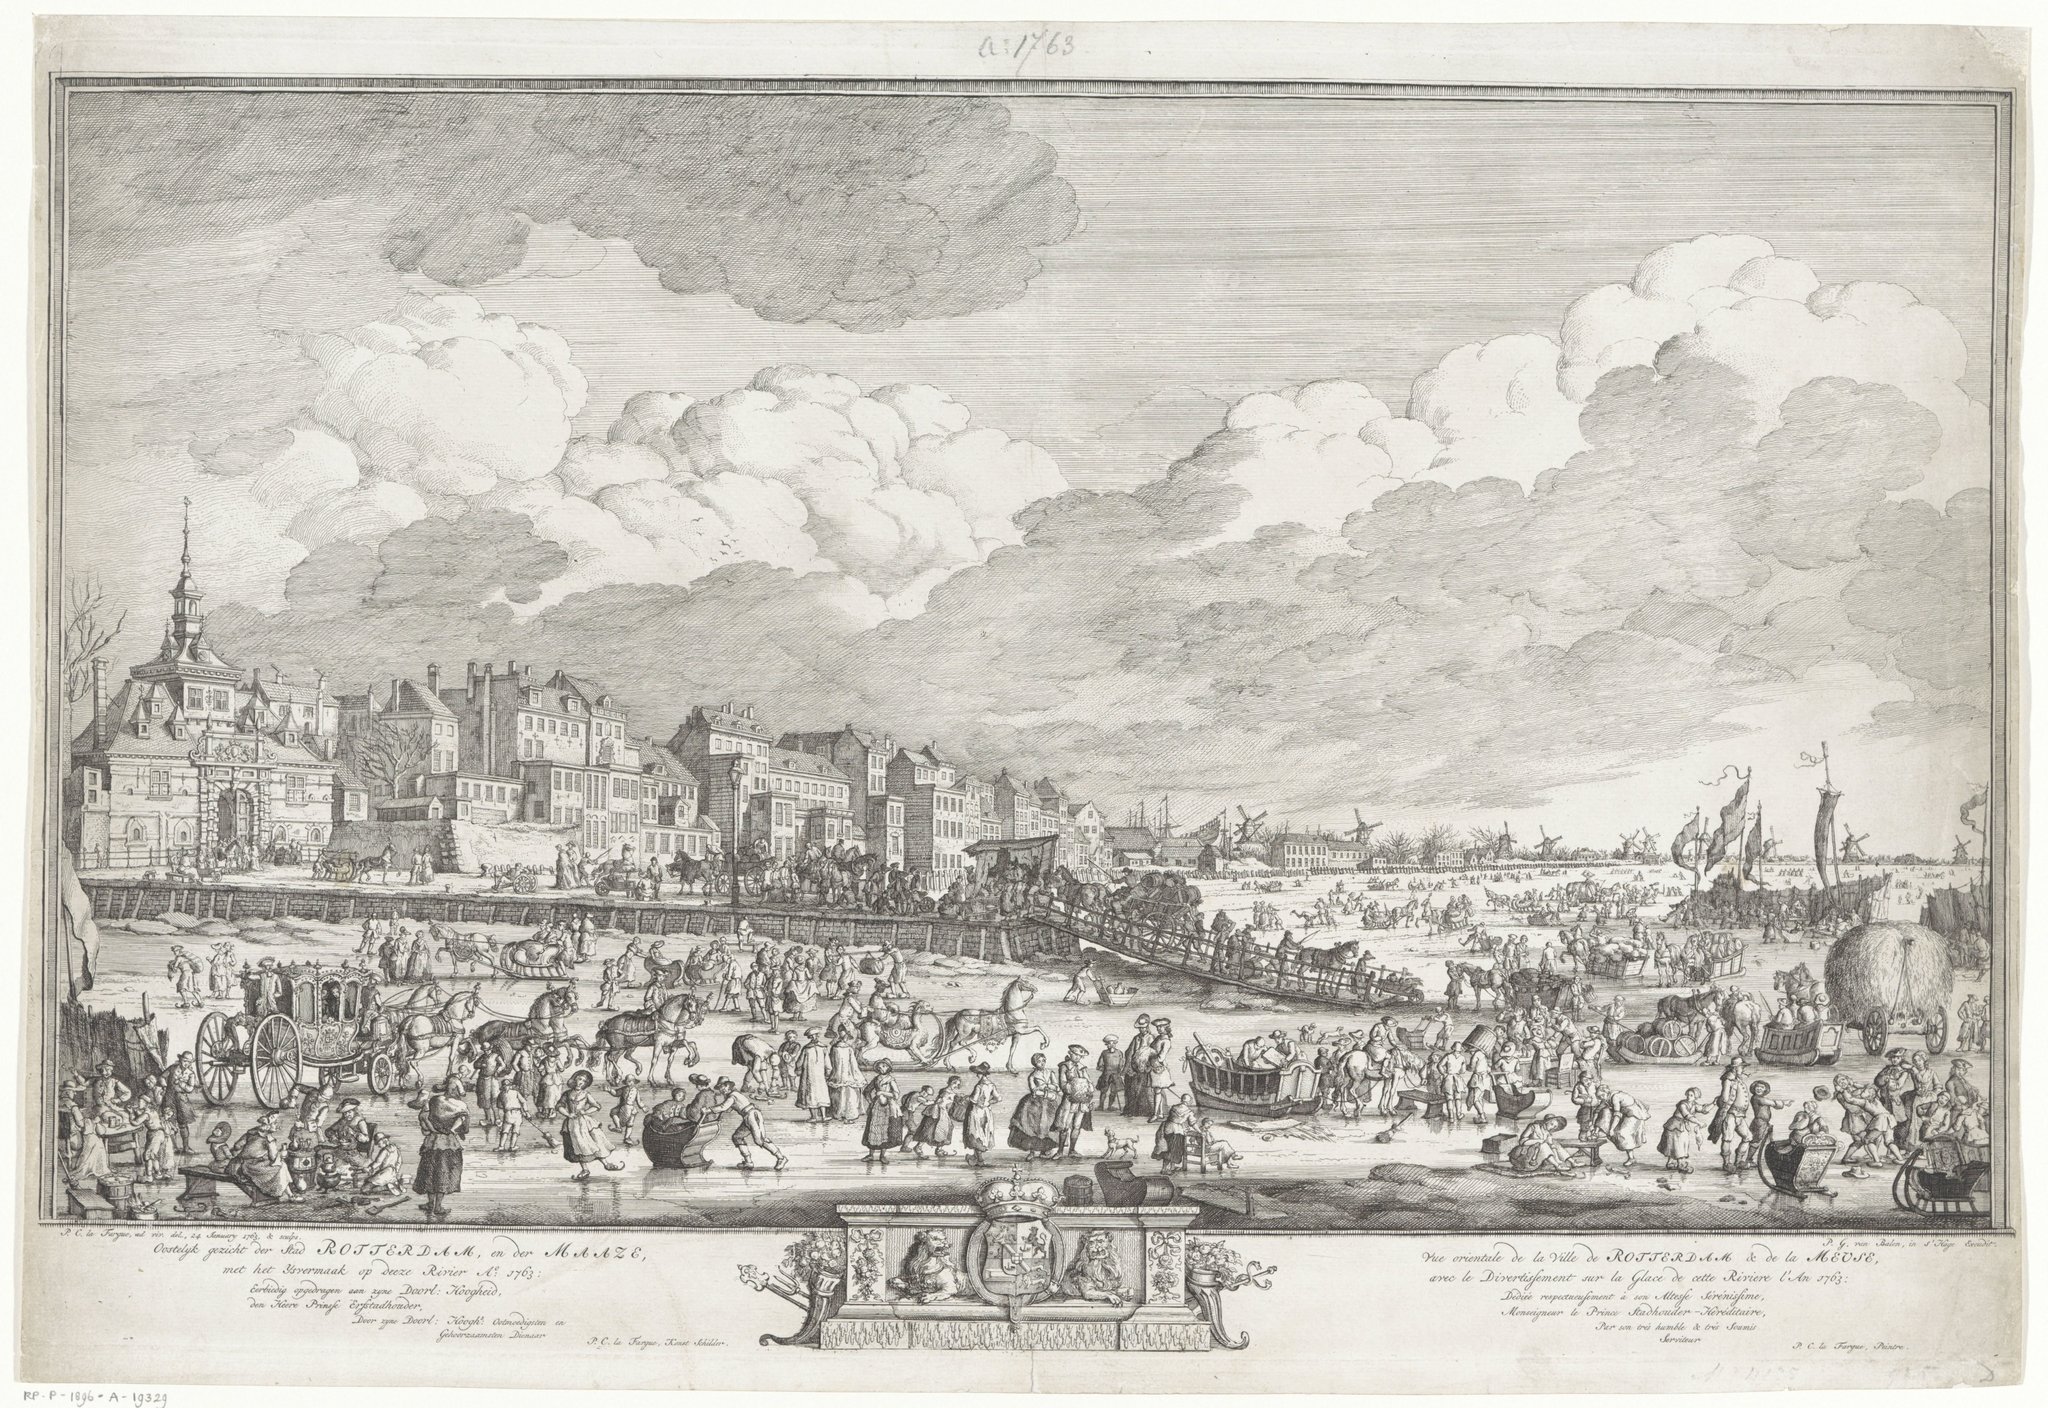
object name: print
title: IJspret op de Maas ter hoogte van Rotterdam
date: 1763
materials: paper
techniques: engraving, etching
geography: northern netherlands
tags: with chair on ice, skates (winter sports), playing with snow and ice, rotterdam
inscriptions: collector's mark: Lugt 2228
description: Gezicht op het oosten van Rotterdam met de bevroren Maas. Op de Maas is een grote menigte te zien. Er wordt geschaatst, gesleed, gegeten en gedronken. Ook vinden er goederentransporten plaats over het ijs. Links rijdt een koets. Onder de voostelling het wapen van erfstadhouder Willem V. Links en rechts de titel van de prent en de opdracht in het Nederlands en Frans.